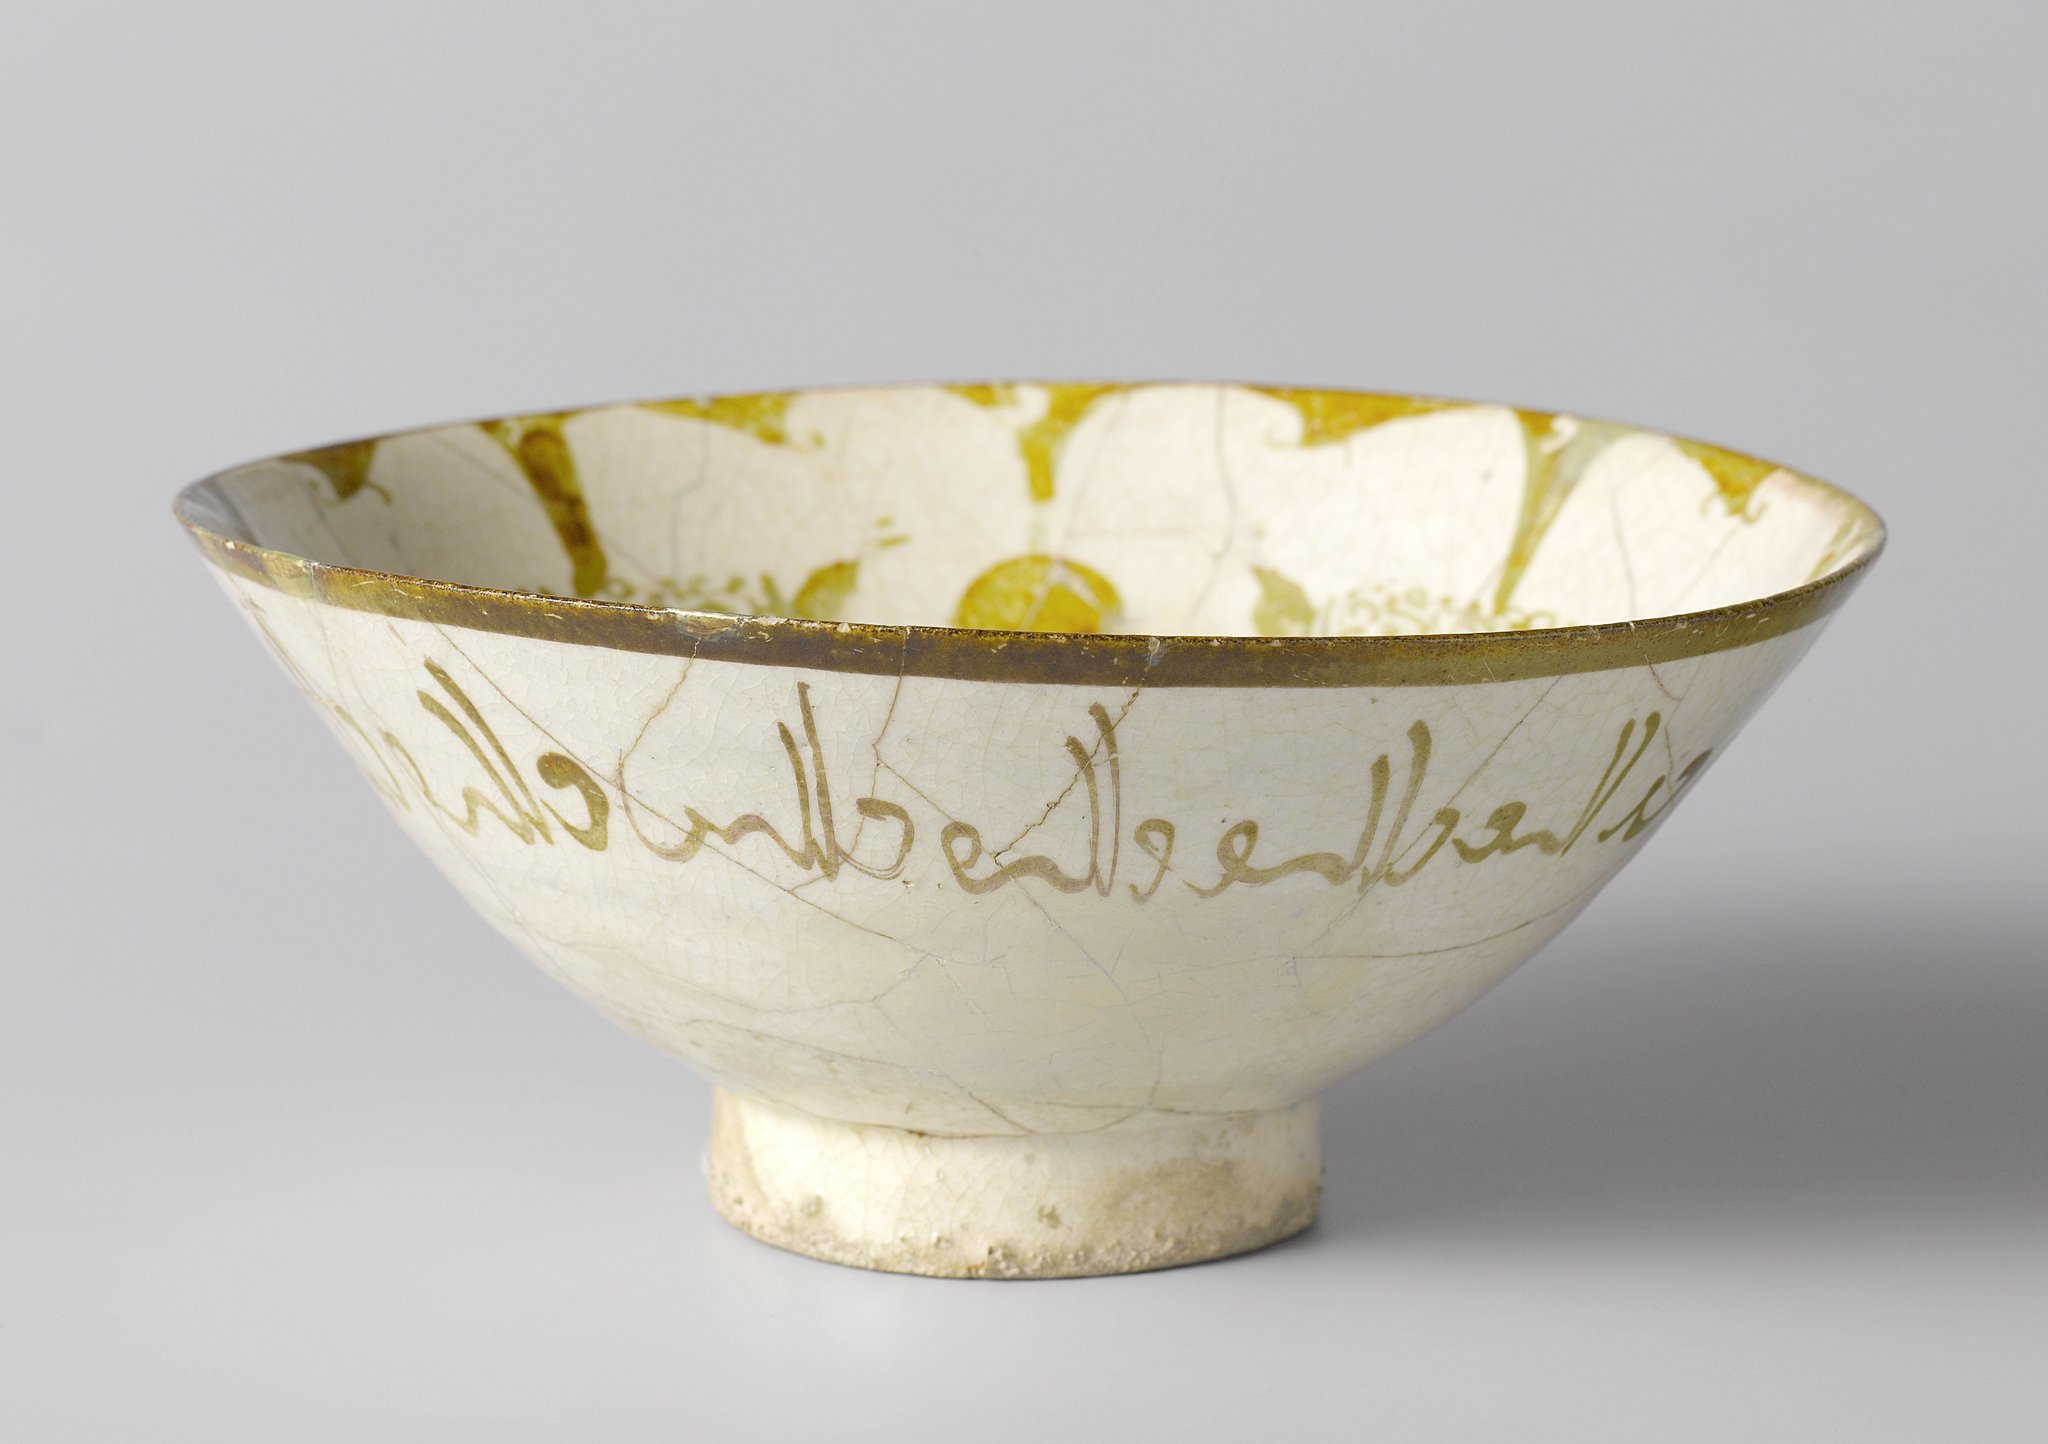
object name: bowl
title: Bowl with an inscription and floral motifs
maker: Anonymous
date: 1170-1200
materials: earthenware, glaze, luster, paint, quartz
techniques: firing, turning, vitrification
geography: kashan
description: Kom van kwarts-fritgoed gedecoreerd met opschriften en plantmotieven in luster op ondergrond van opaak wit tin-lood-alkaliglazuur.